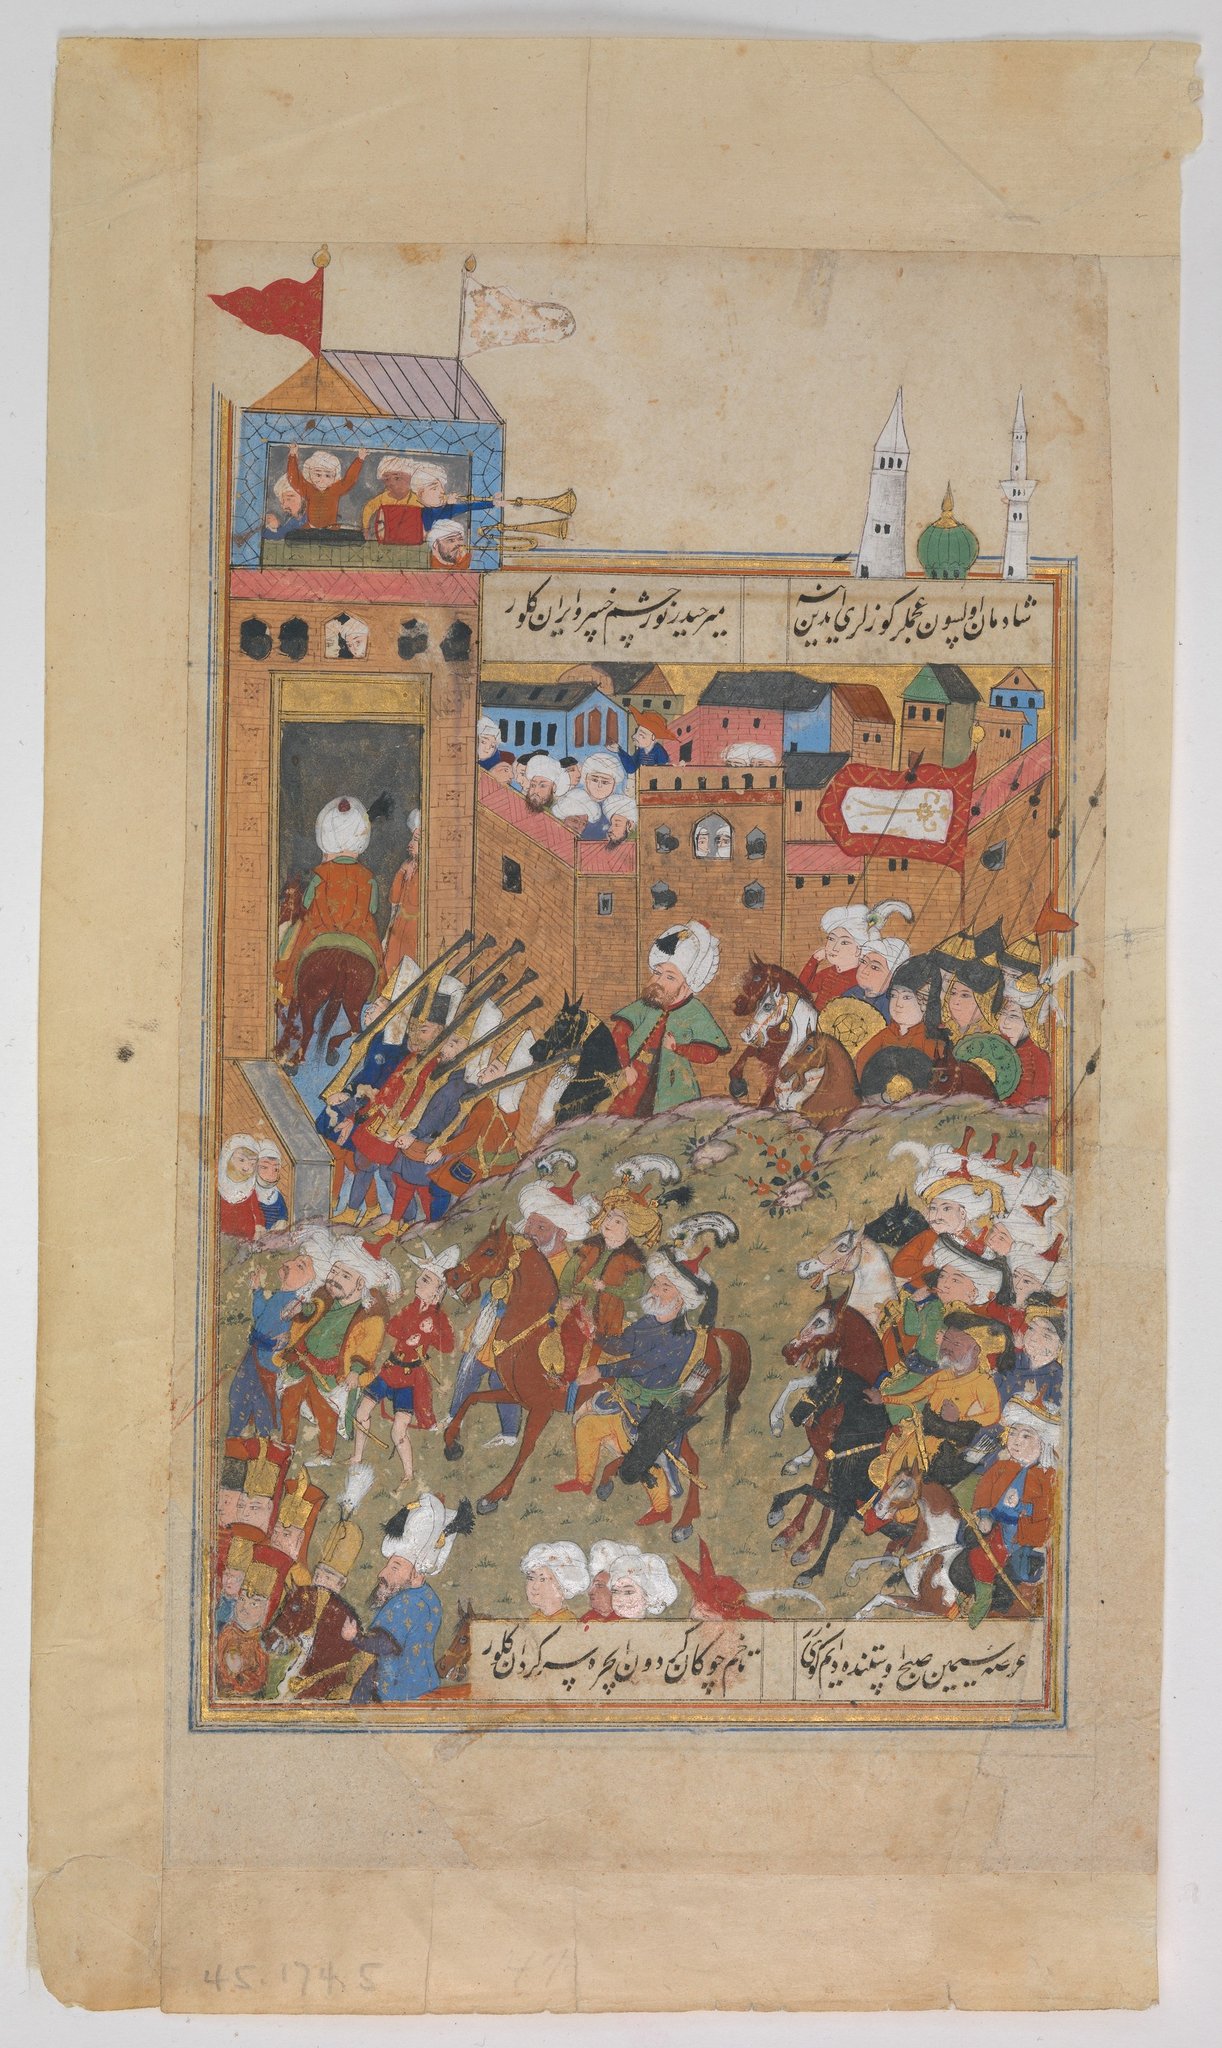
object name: folio from an illustrated manuscript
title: "Ottoman Army Entering a City", Folio from a Divan of Mahmud `Abd al-Baqi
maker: mahmud 'abd-al baqi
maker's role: poet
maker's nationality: ottoman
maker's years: 1526-1600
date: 1576-1600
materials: gold, ink, paper, watercolor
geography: turkey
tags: army,soldiers,men,horses